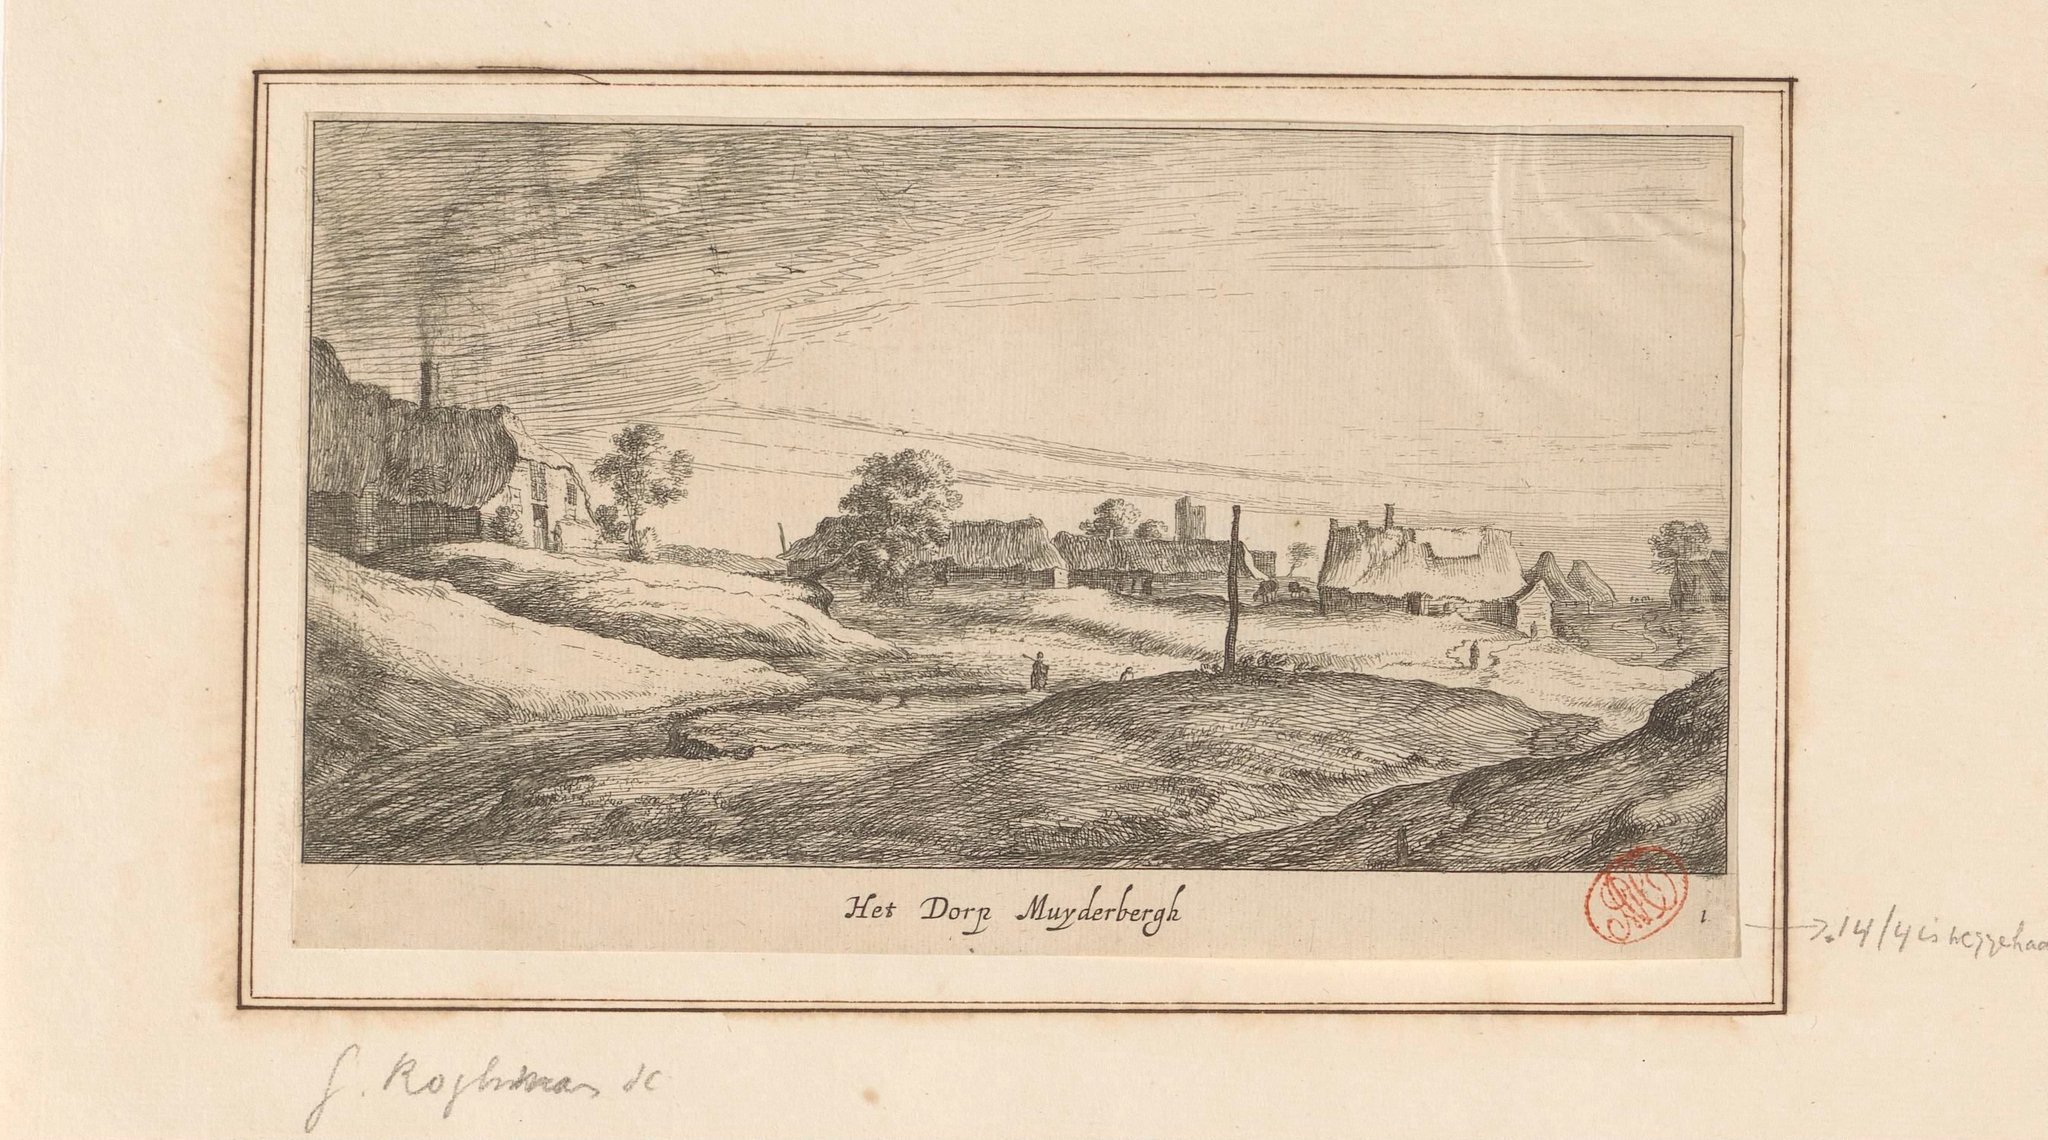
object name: print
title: Het dorp Muyderbergh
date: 1637-1652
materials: paper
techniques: engraving, etching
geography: amsterdam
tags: prospect of village, silhouette of village, ruin of church, monastery, etc.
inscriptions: collector's mark: Lugt 195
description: Gezicht op het dorp Muiderberg, met enkele boerderijtjes en op de achtergrond de vervallen toren van de oude kerk. De prent is deel van een serie landschappen met dorpen rondom Amsterdam. Rechtsonder genummerd: 1.